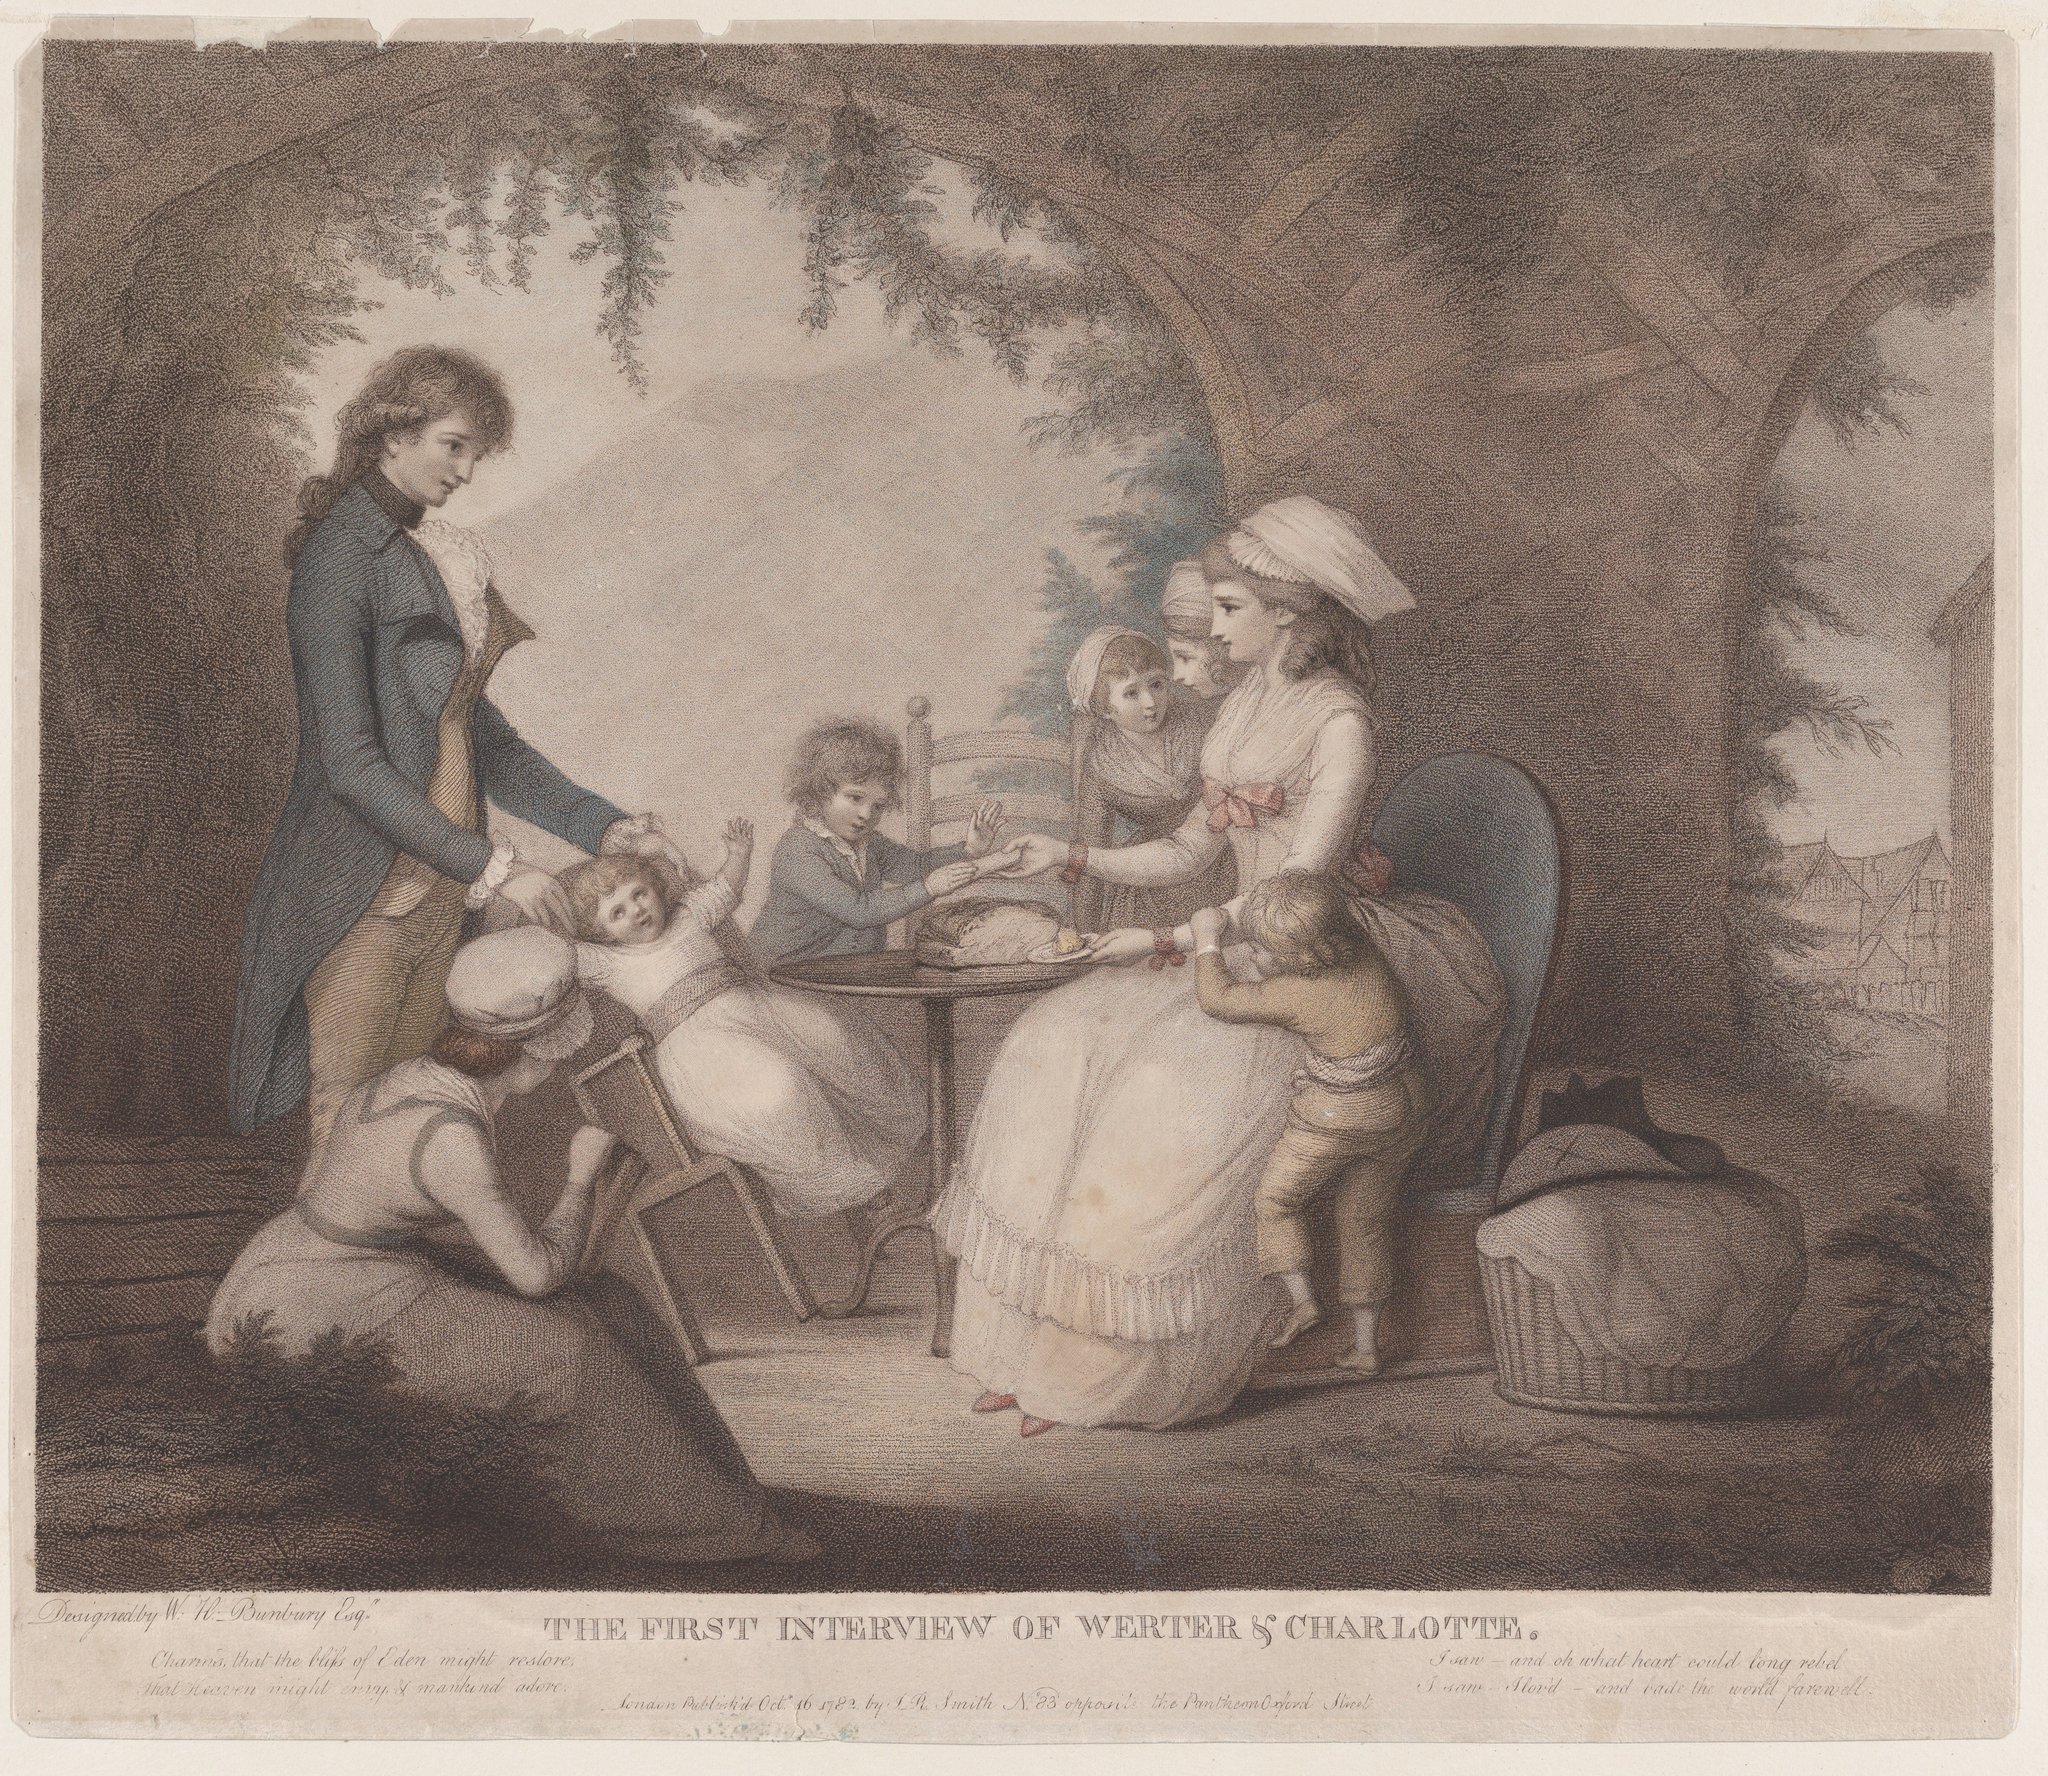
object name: print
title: The First Interview of Werther and Charlotte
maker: john raphael smith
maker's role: engraver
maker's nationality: british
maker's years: 1751-1812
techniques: etching, hand coloring, stippling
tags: bread,children,men,women